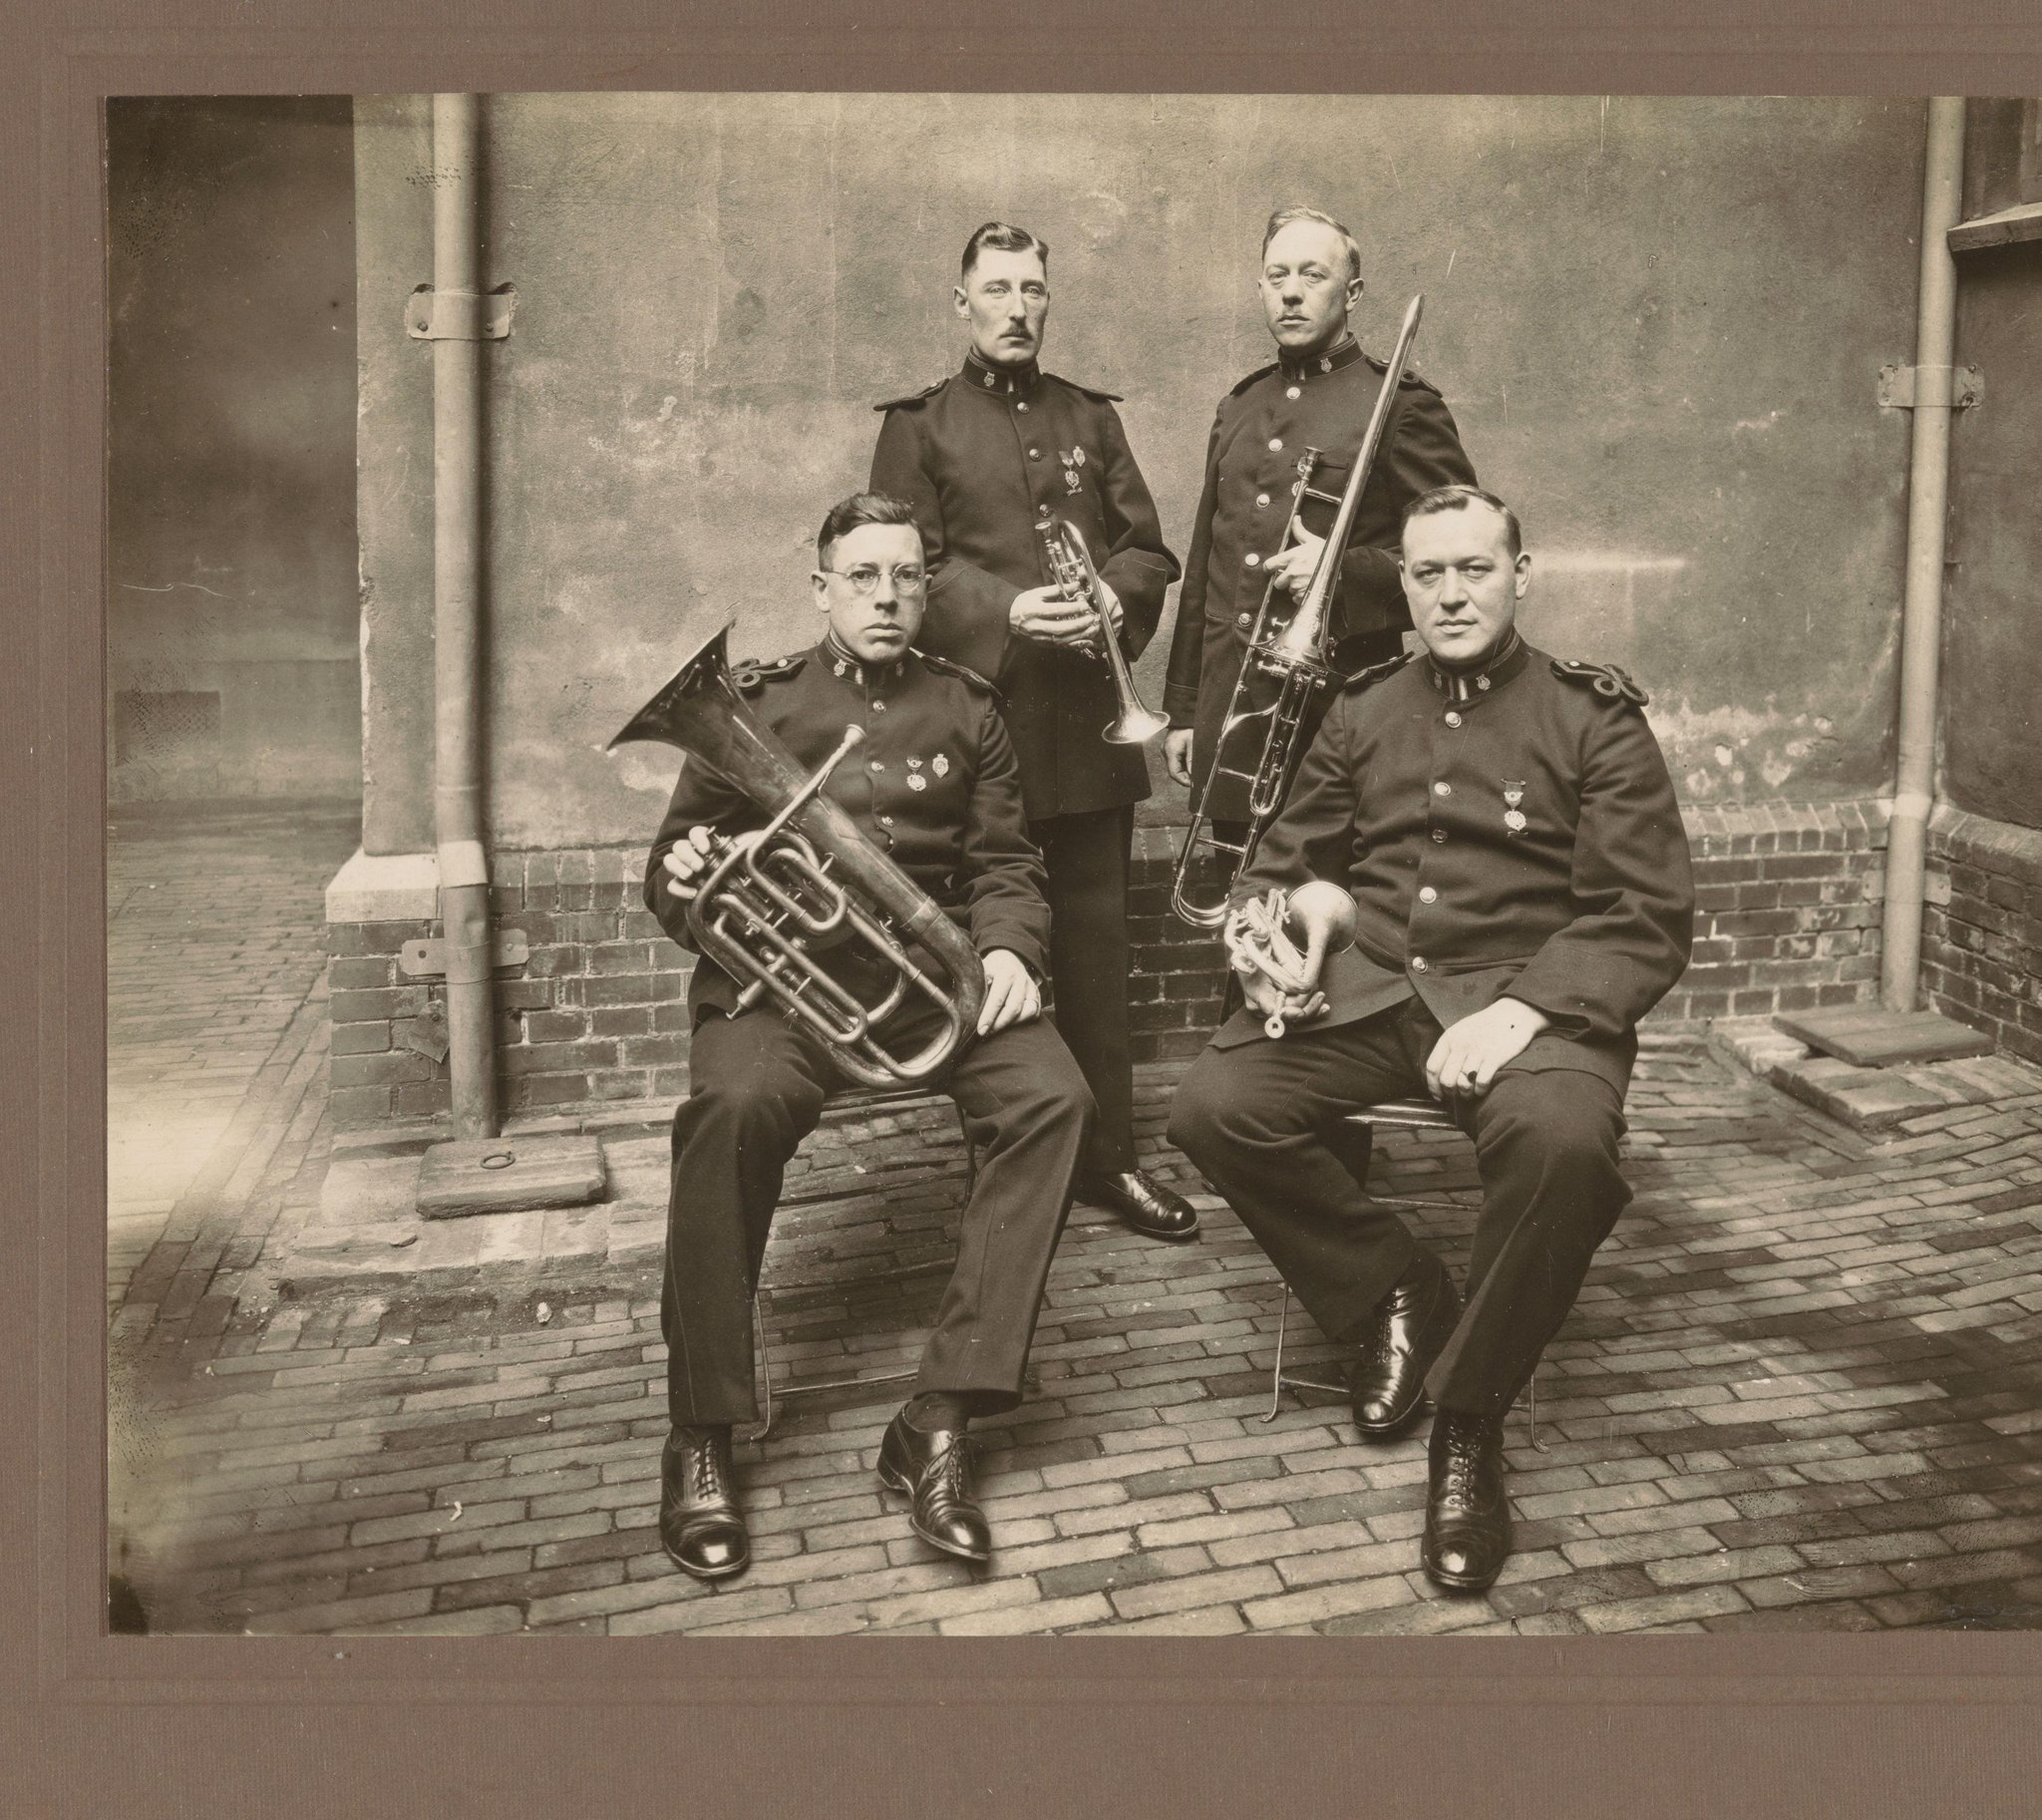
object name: photograph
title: Portret van vier onbekende leden van de Amsterdamsche Postharmonie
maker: Anonymous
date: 1930-1950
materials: paper, cardboard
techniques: gelatin silver print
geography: amsterdam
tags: brass band, street band - cc - out of doors, anonymous historical persons portrayed in a group, in a group-portrait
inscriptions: number: ‘6’